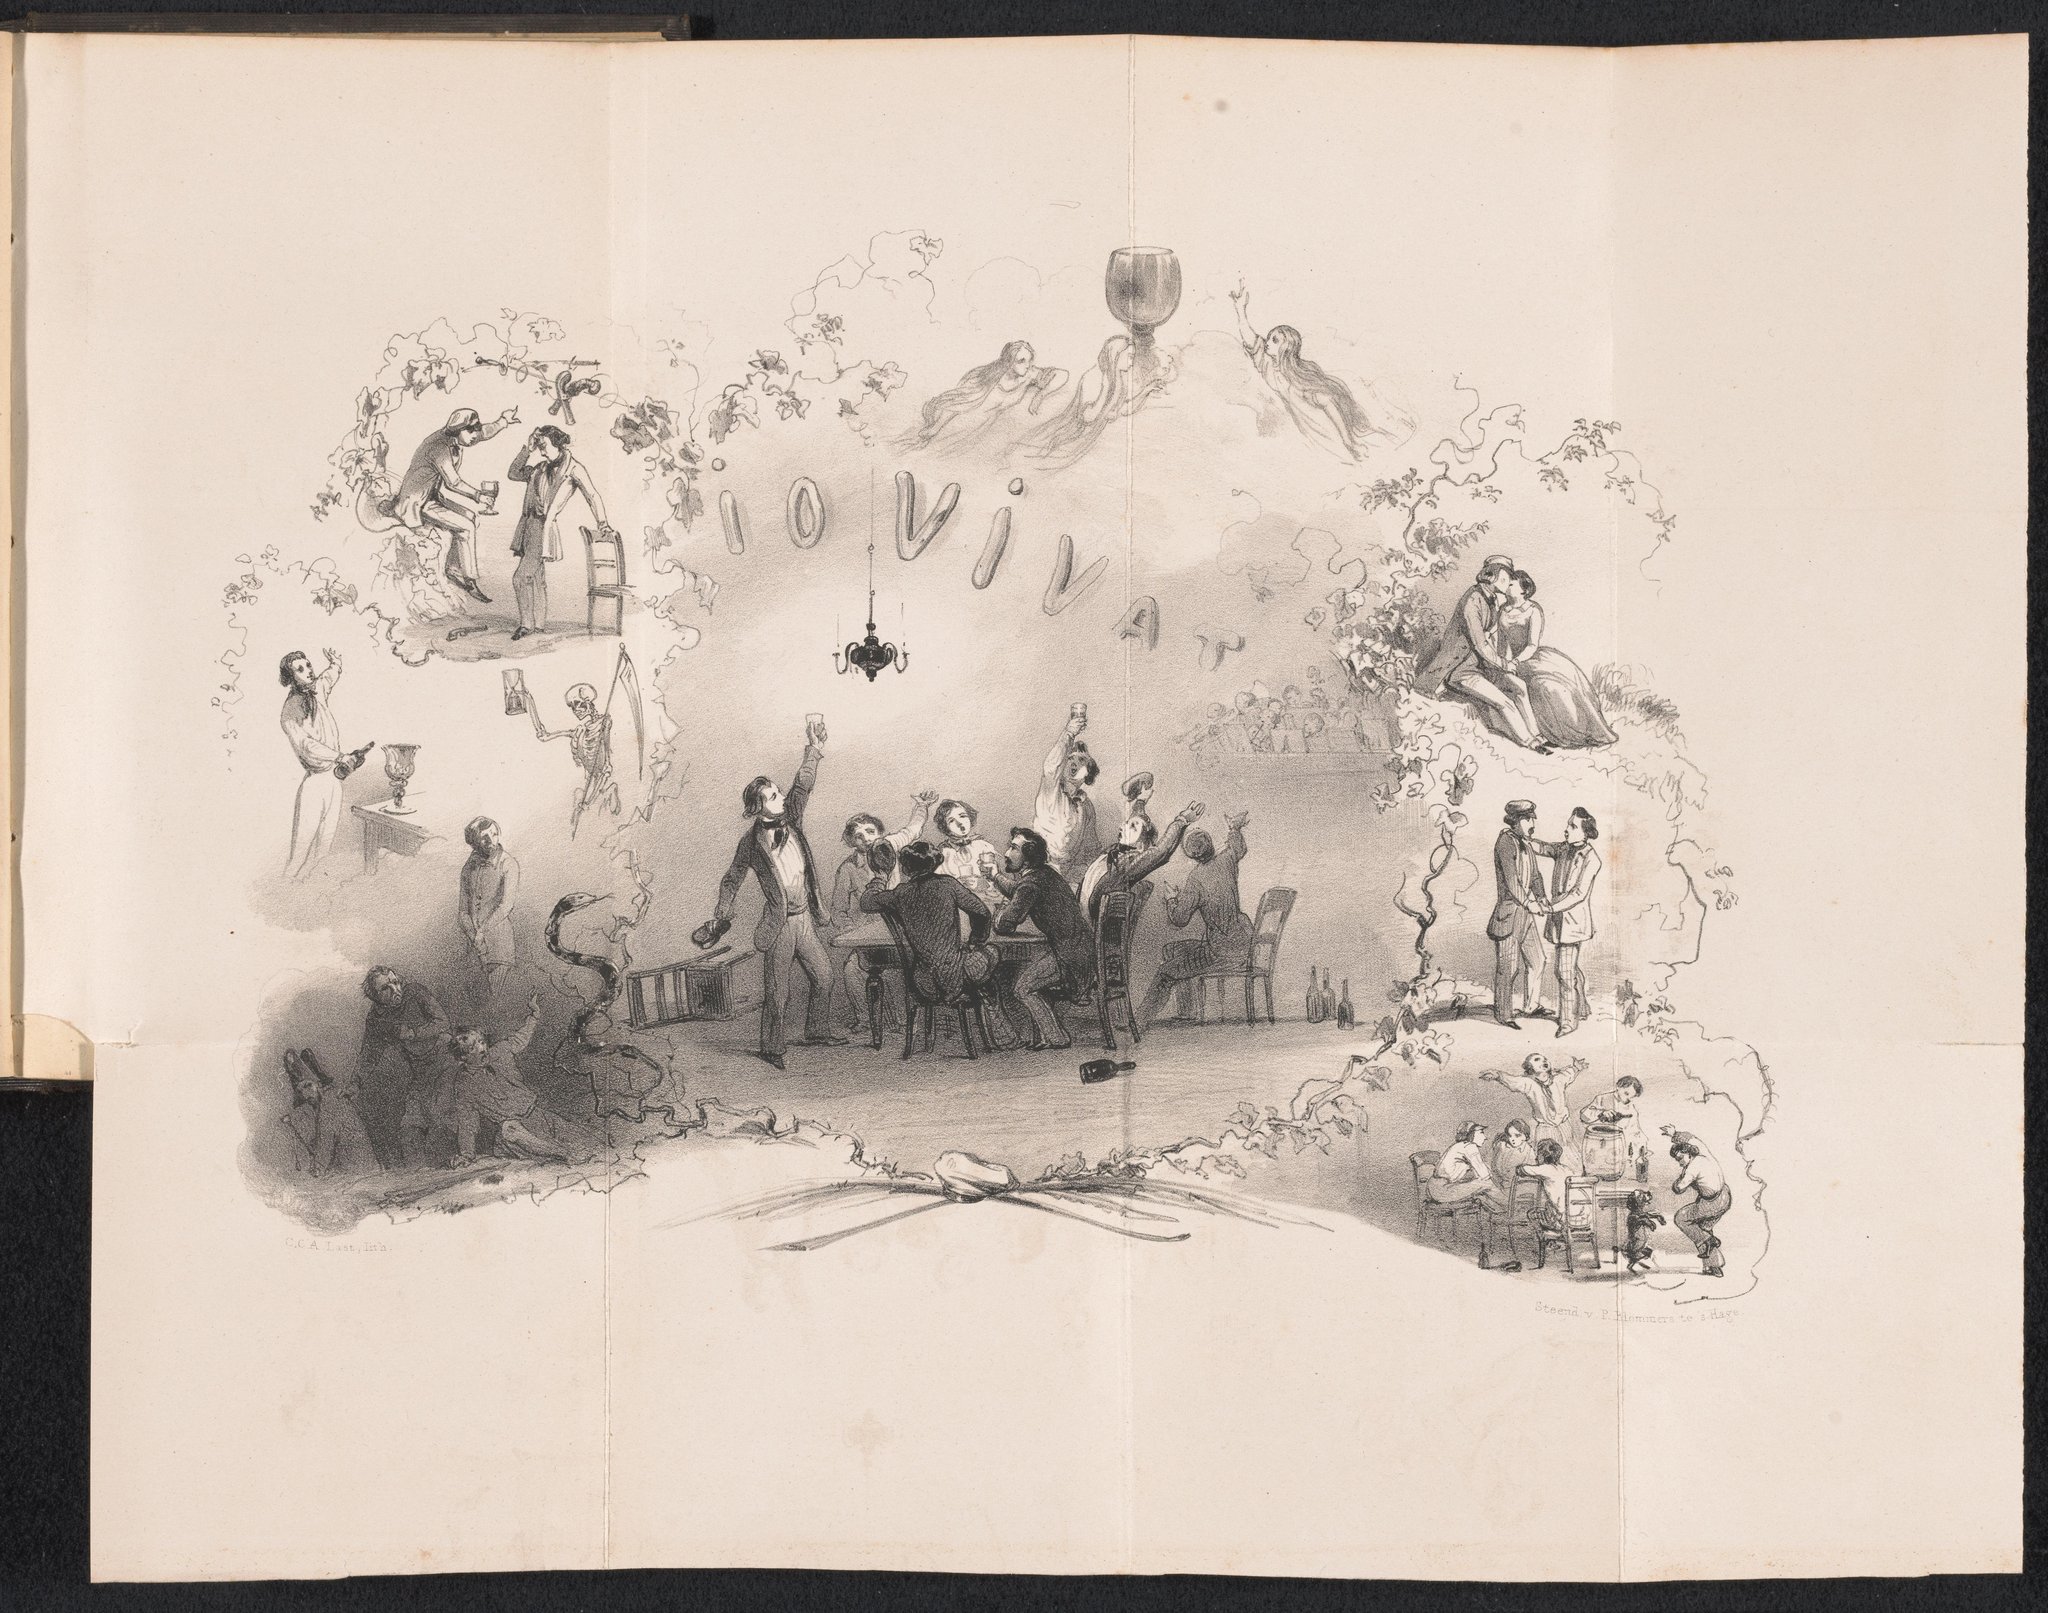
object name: print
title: Io vivat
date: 1849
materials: paper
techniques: lithograph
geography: netherlands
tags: student life, leiden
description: Een zingend studentengezelschap onder het opschrift 'Io Vivat', omringd door kleine voorstellingen uit het studentenleven. Spotprent in de studentenalmanak van de Universiteit van Leiden van het jaar 1849.